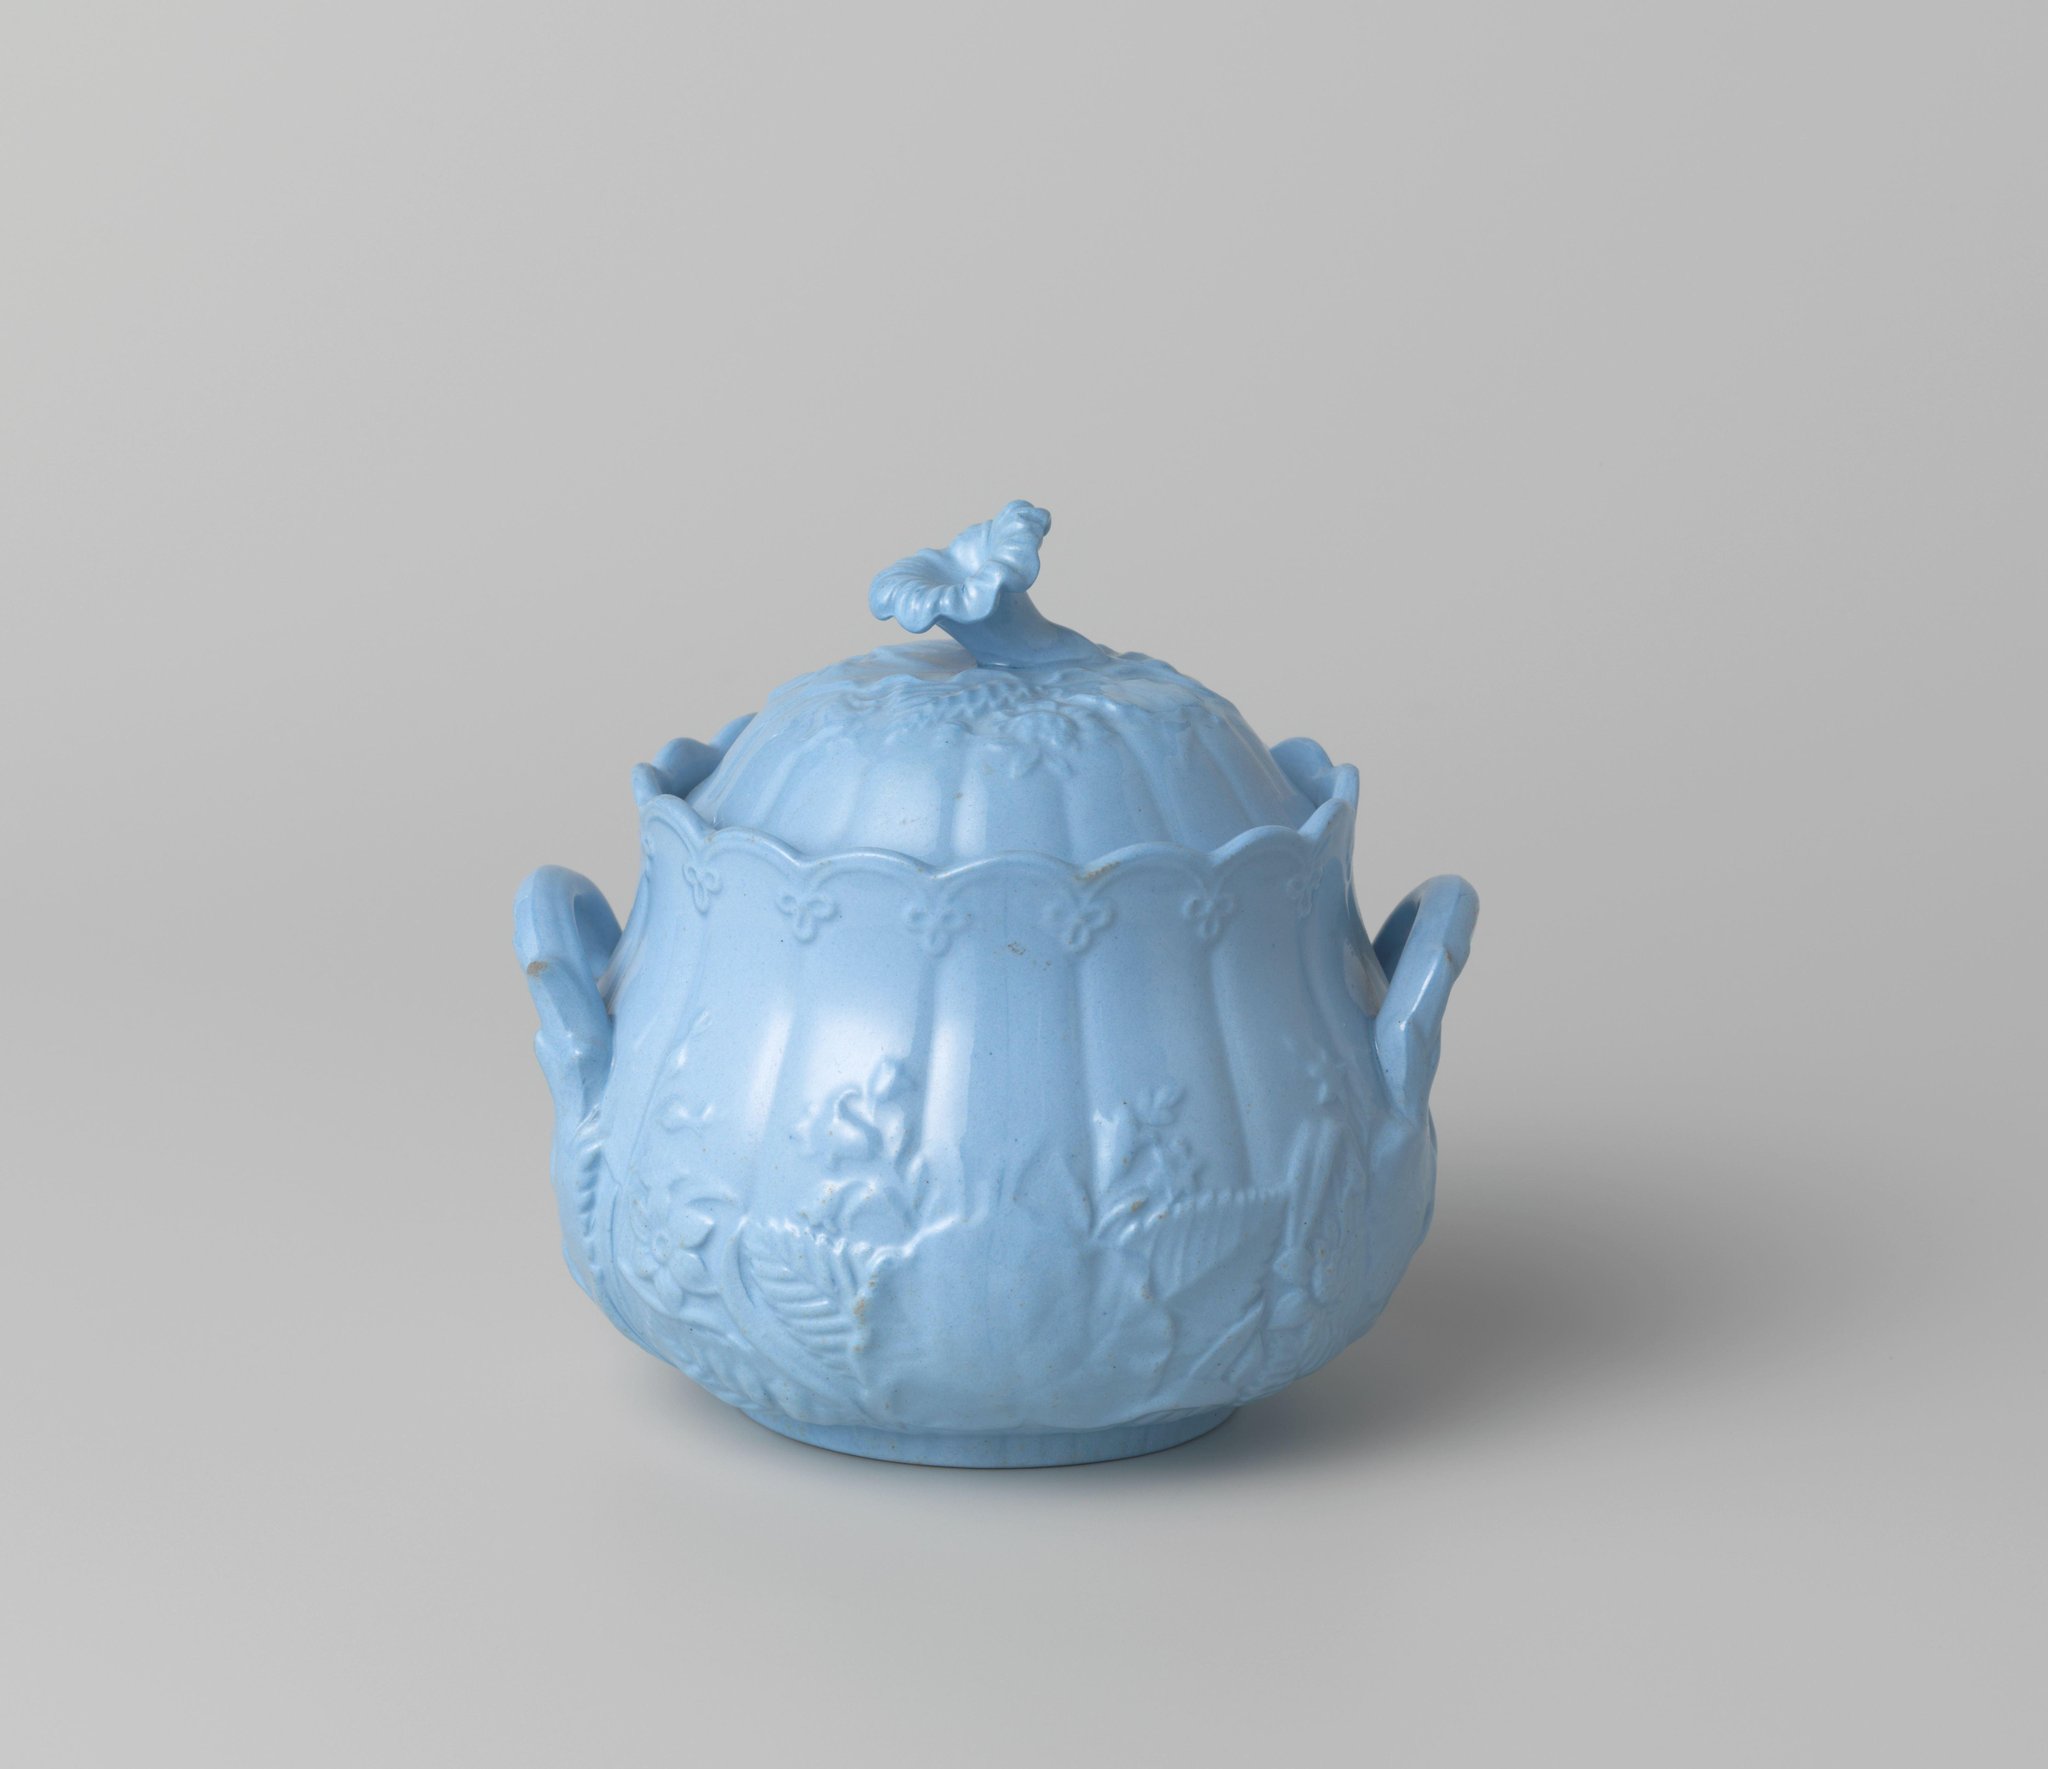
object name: sugar box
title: Suikerpot, blauw, met bloemen en bladeren in reliëf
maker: petrus regout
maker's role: plateelbakker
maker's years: 1801-1879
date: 1860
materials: stoneware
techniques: engels steengoed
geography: maastricht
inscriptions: mark: ‘P. REGOUT // MAASTRICHT // 21’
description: Suikerpot van aardewerk, blauwsteen. De buitenzijde met bloemen en bladeren in reliëf. De twee handvatten opgebouwd uit bladeren en twijgen.